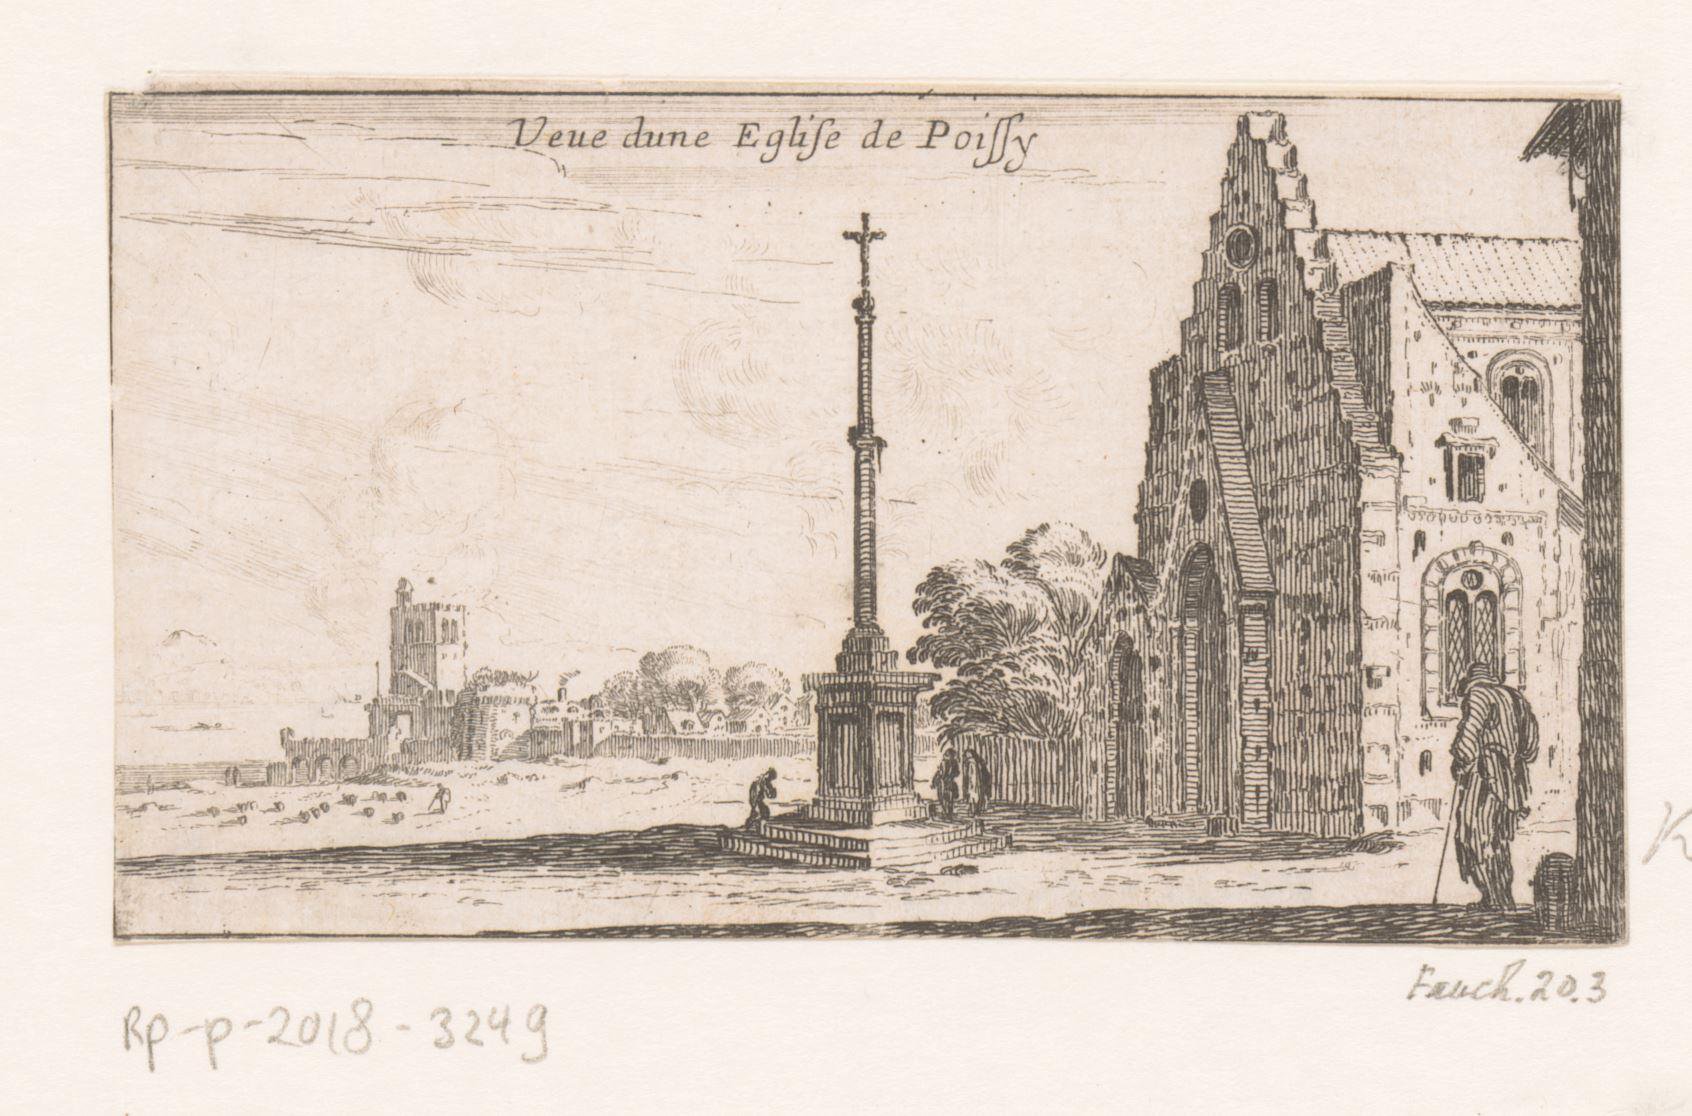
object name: print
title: Diverse Veües de France et d'Italie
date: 1643-1657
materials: paper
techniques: etching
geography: paris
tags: city-view, and landscape with man-made constructions, church (exterior)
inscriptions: collector's mark: Lugt 240, collector's mark: Lugt 2228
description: Prent maakt deel uit van een serie van twaalf prenten.